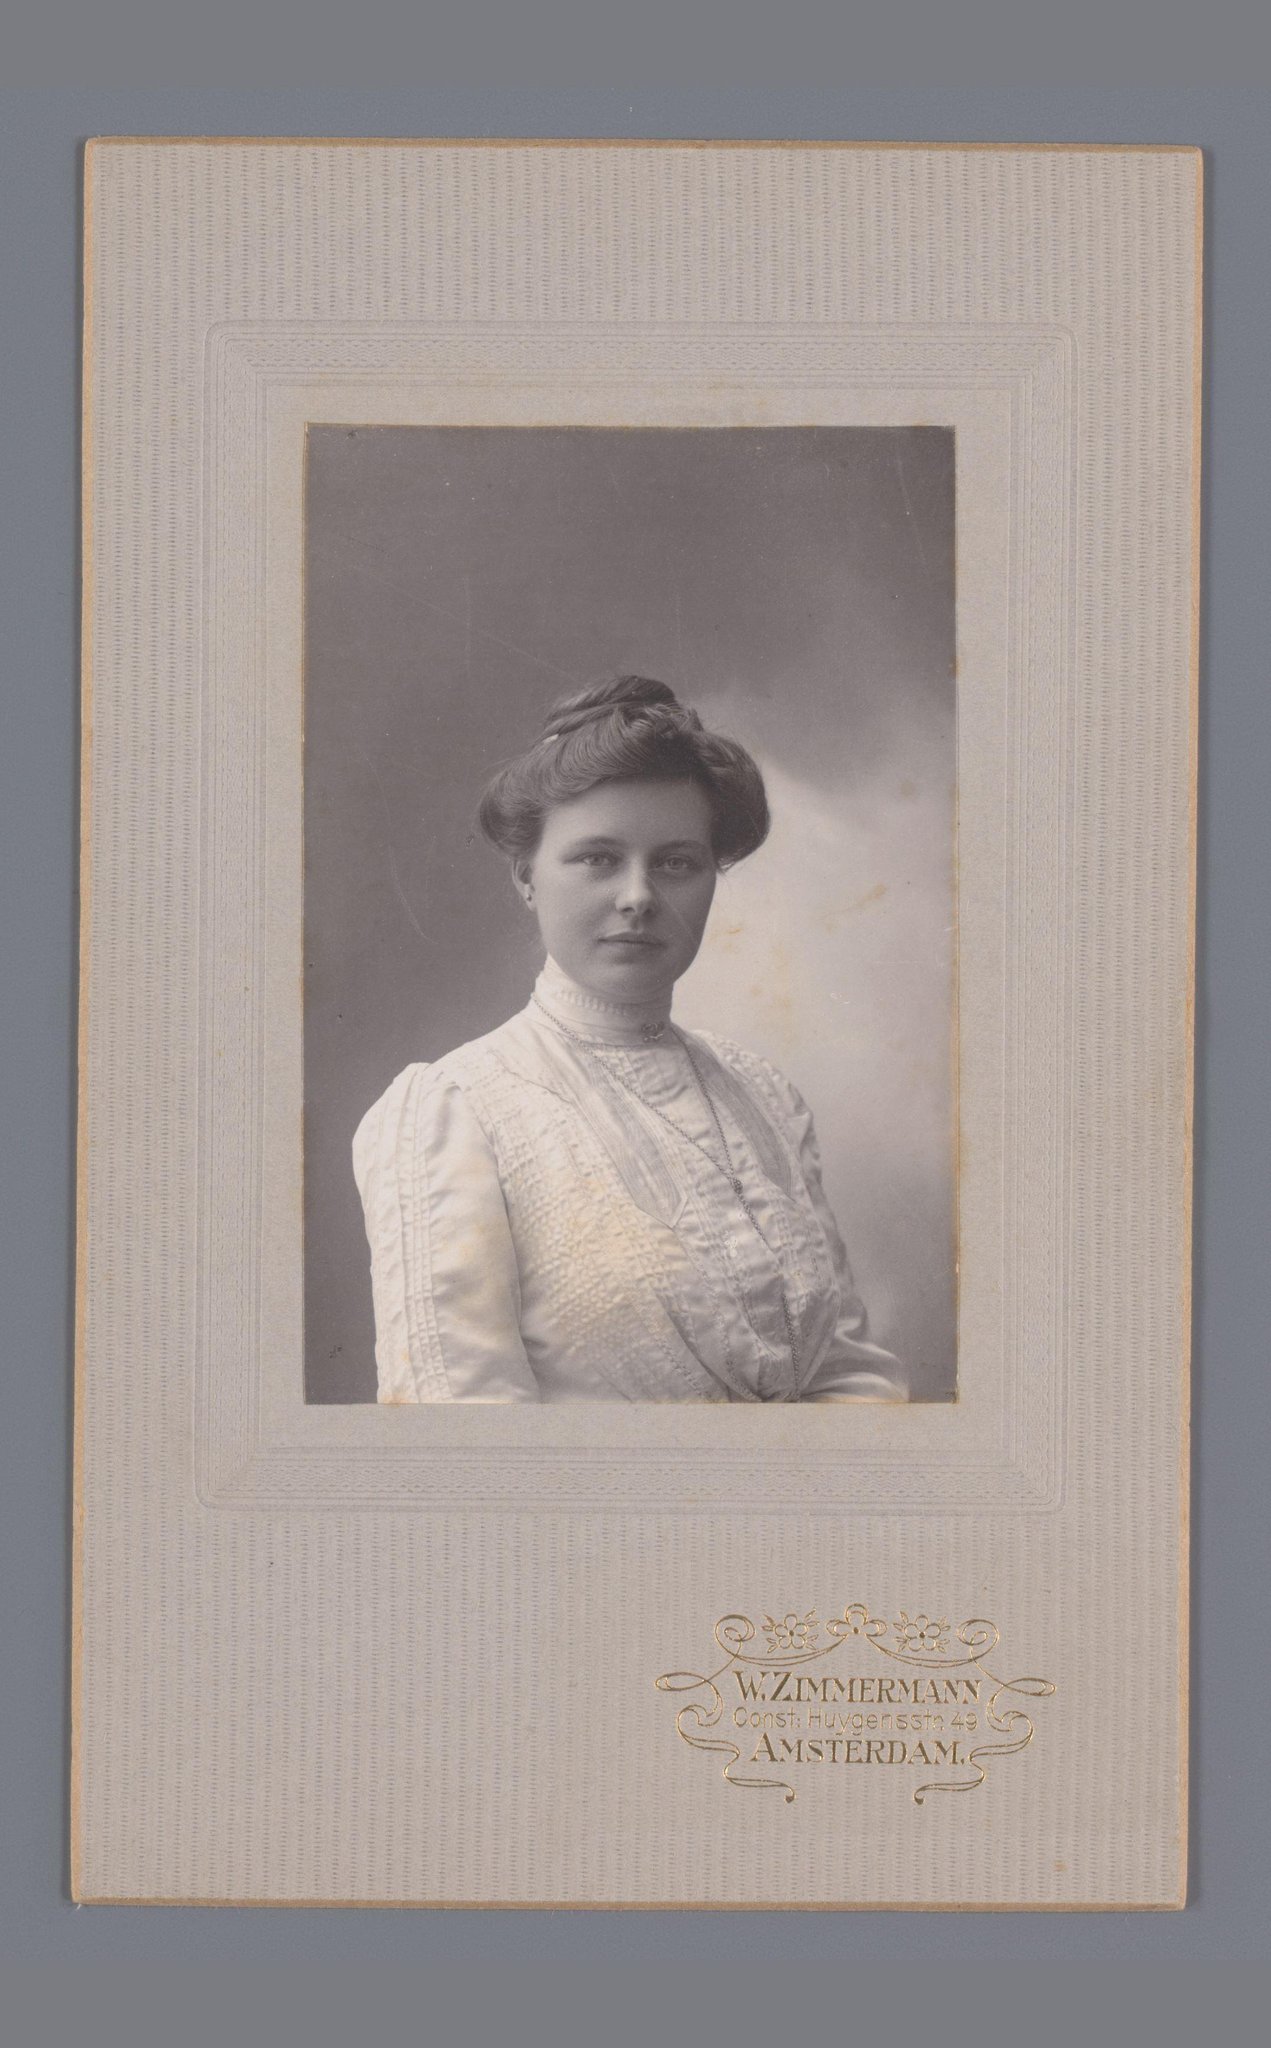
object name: photograph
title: Portret van Lucie Keyser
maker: guillame maximilien zimmermann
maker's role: fotograaf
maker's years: 1873-1951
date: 1880-1940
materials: cardboard, photographic support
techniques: collodion silver print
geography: amsterdam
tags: historical persons, amsterdam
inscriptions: annotation: ‘Lucie Keyser’